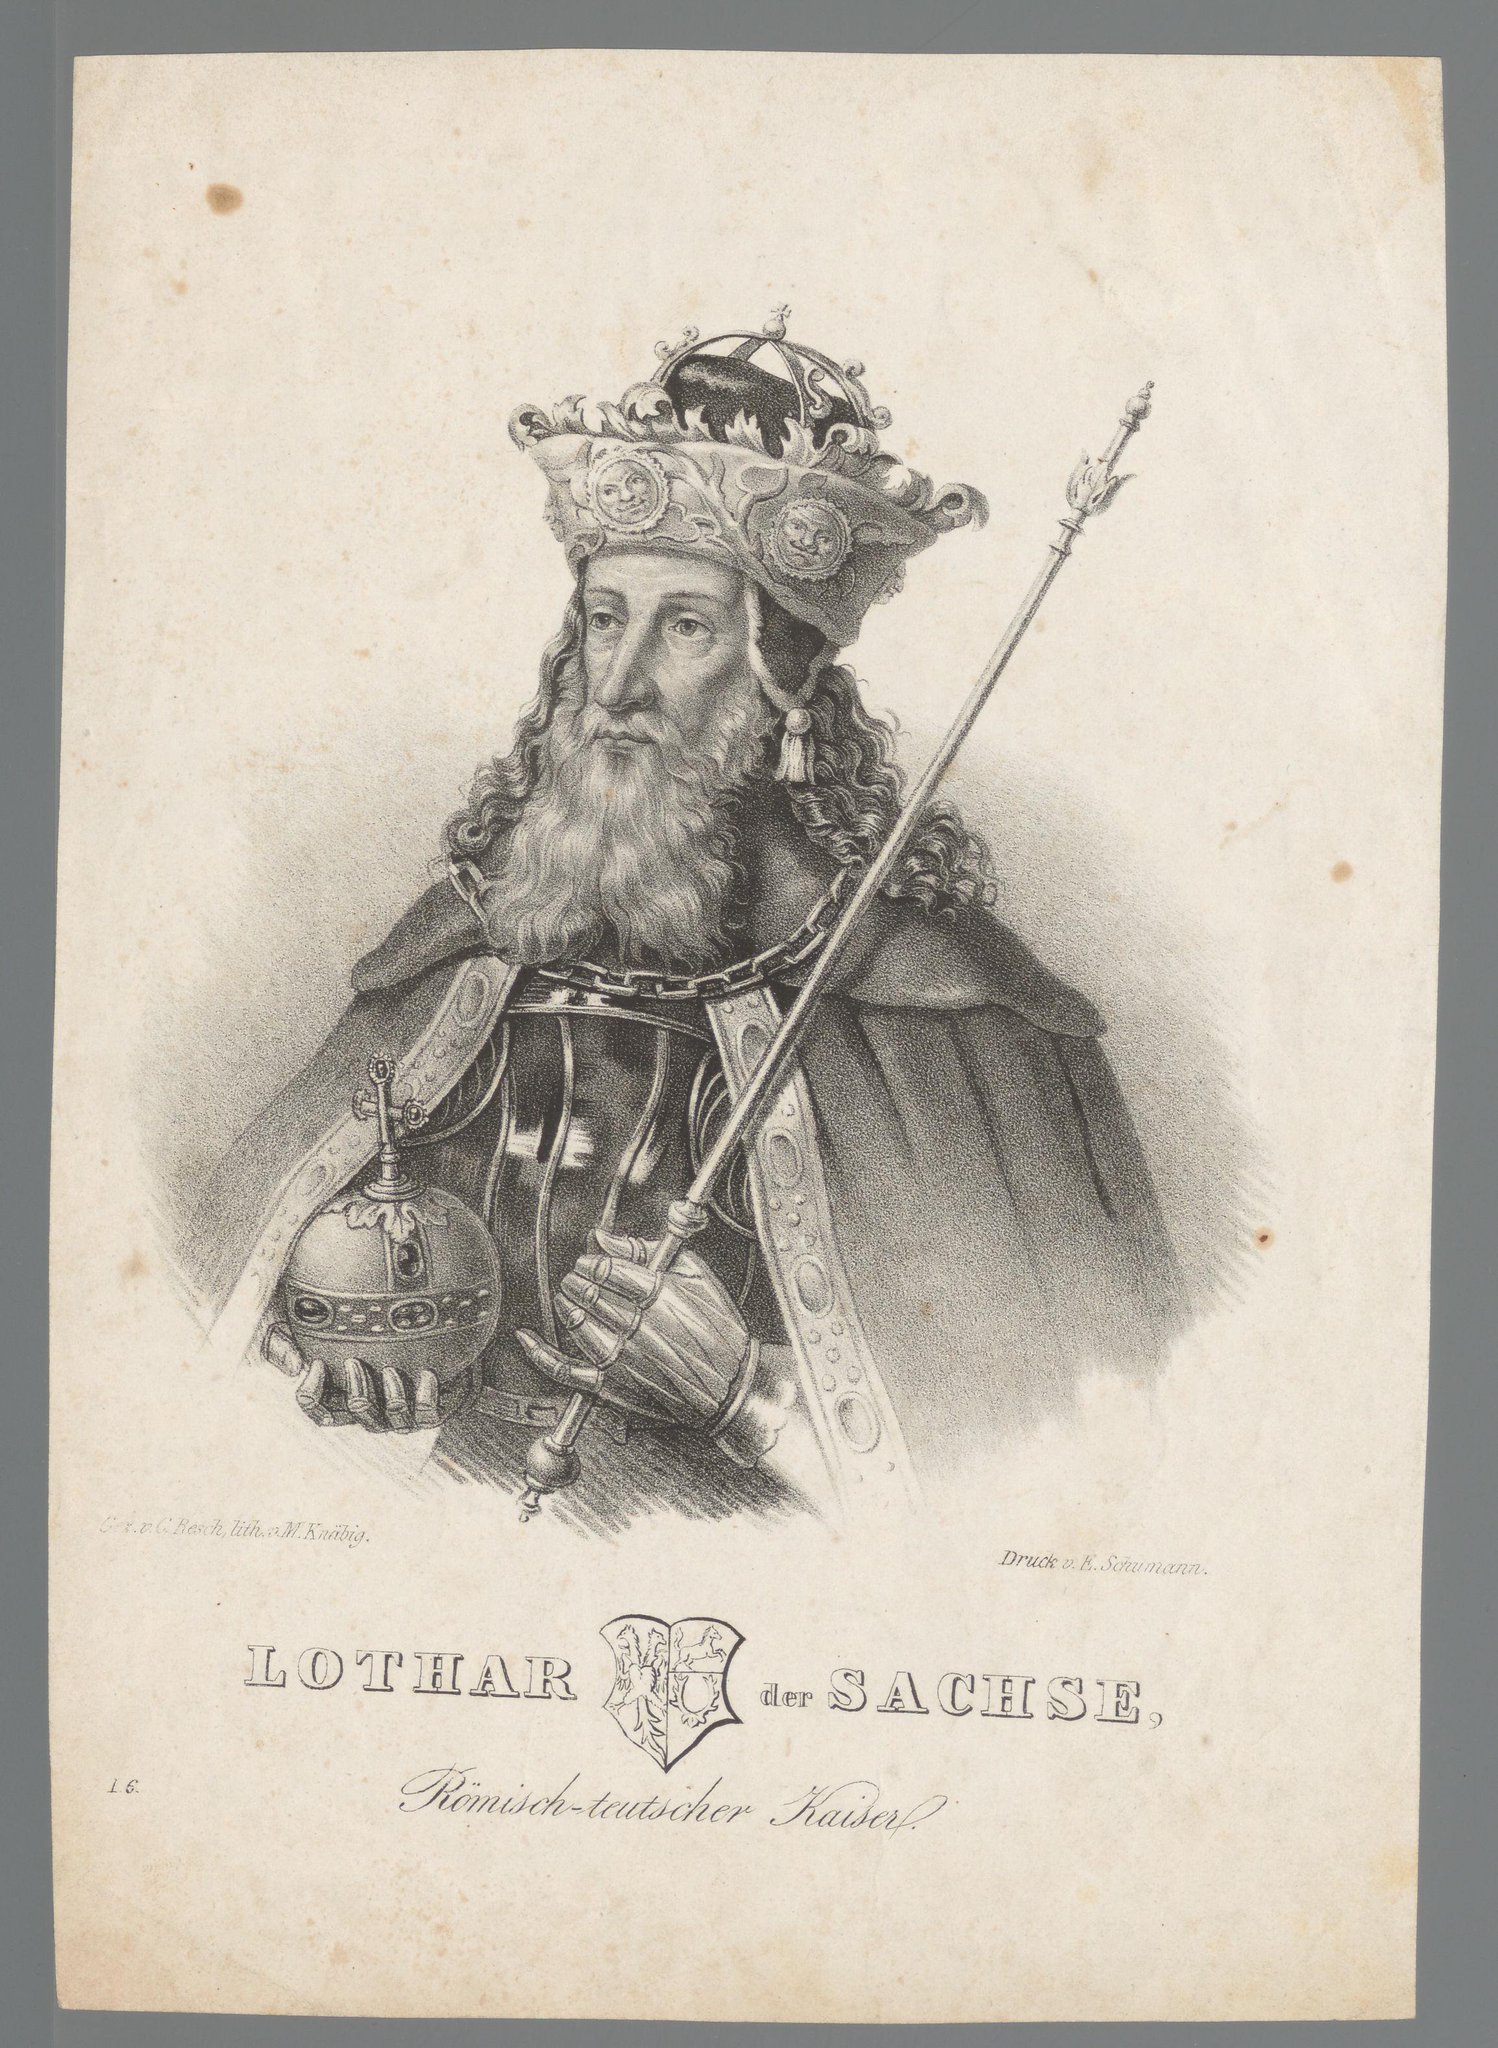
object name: print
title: Lothar der Sachse, Römisch-teutscher Kaiser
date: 1814-1876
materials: paper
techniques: lithograph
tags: adult man, historical persons, insignia and symbols of sovereignty (crown, diadem, sceptre, orb, seal, standard, cloak, pectoral)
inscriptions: collector's mark: Lugt 2228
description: Linksonder: I.6. Waarschijnlijk gaat het om Lotharius I.